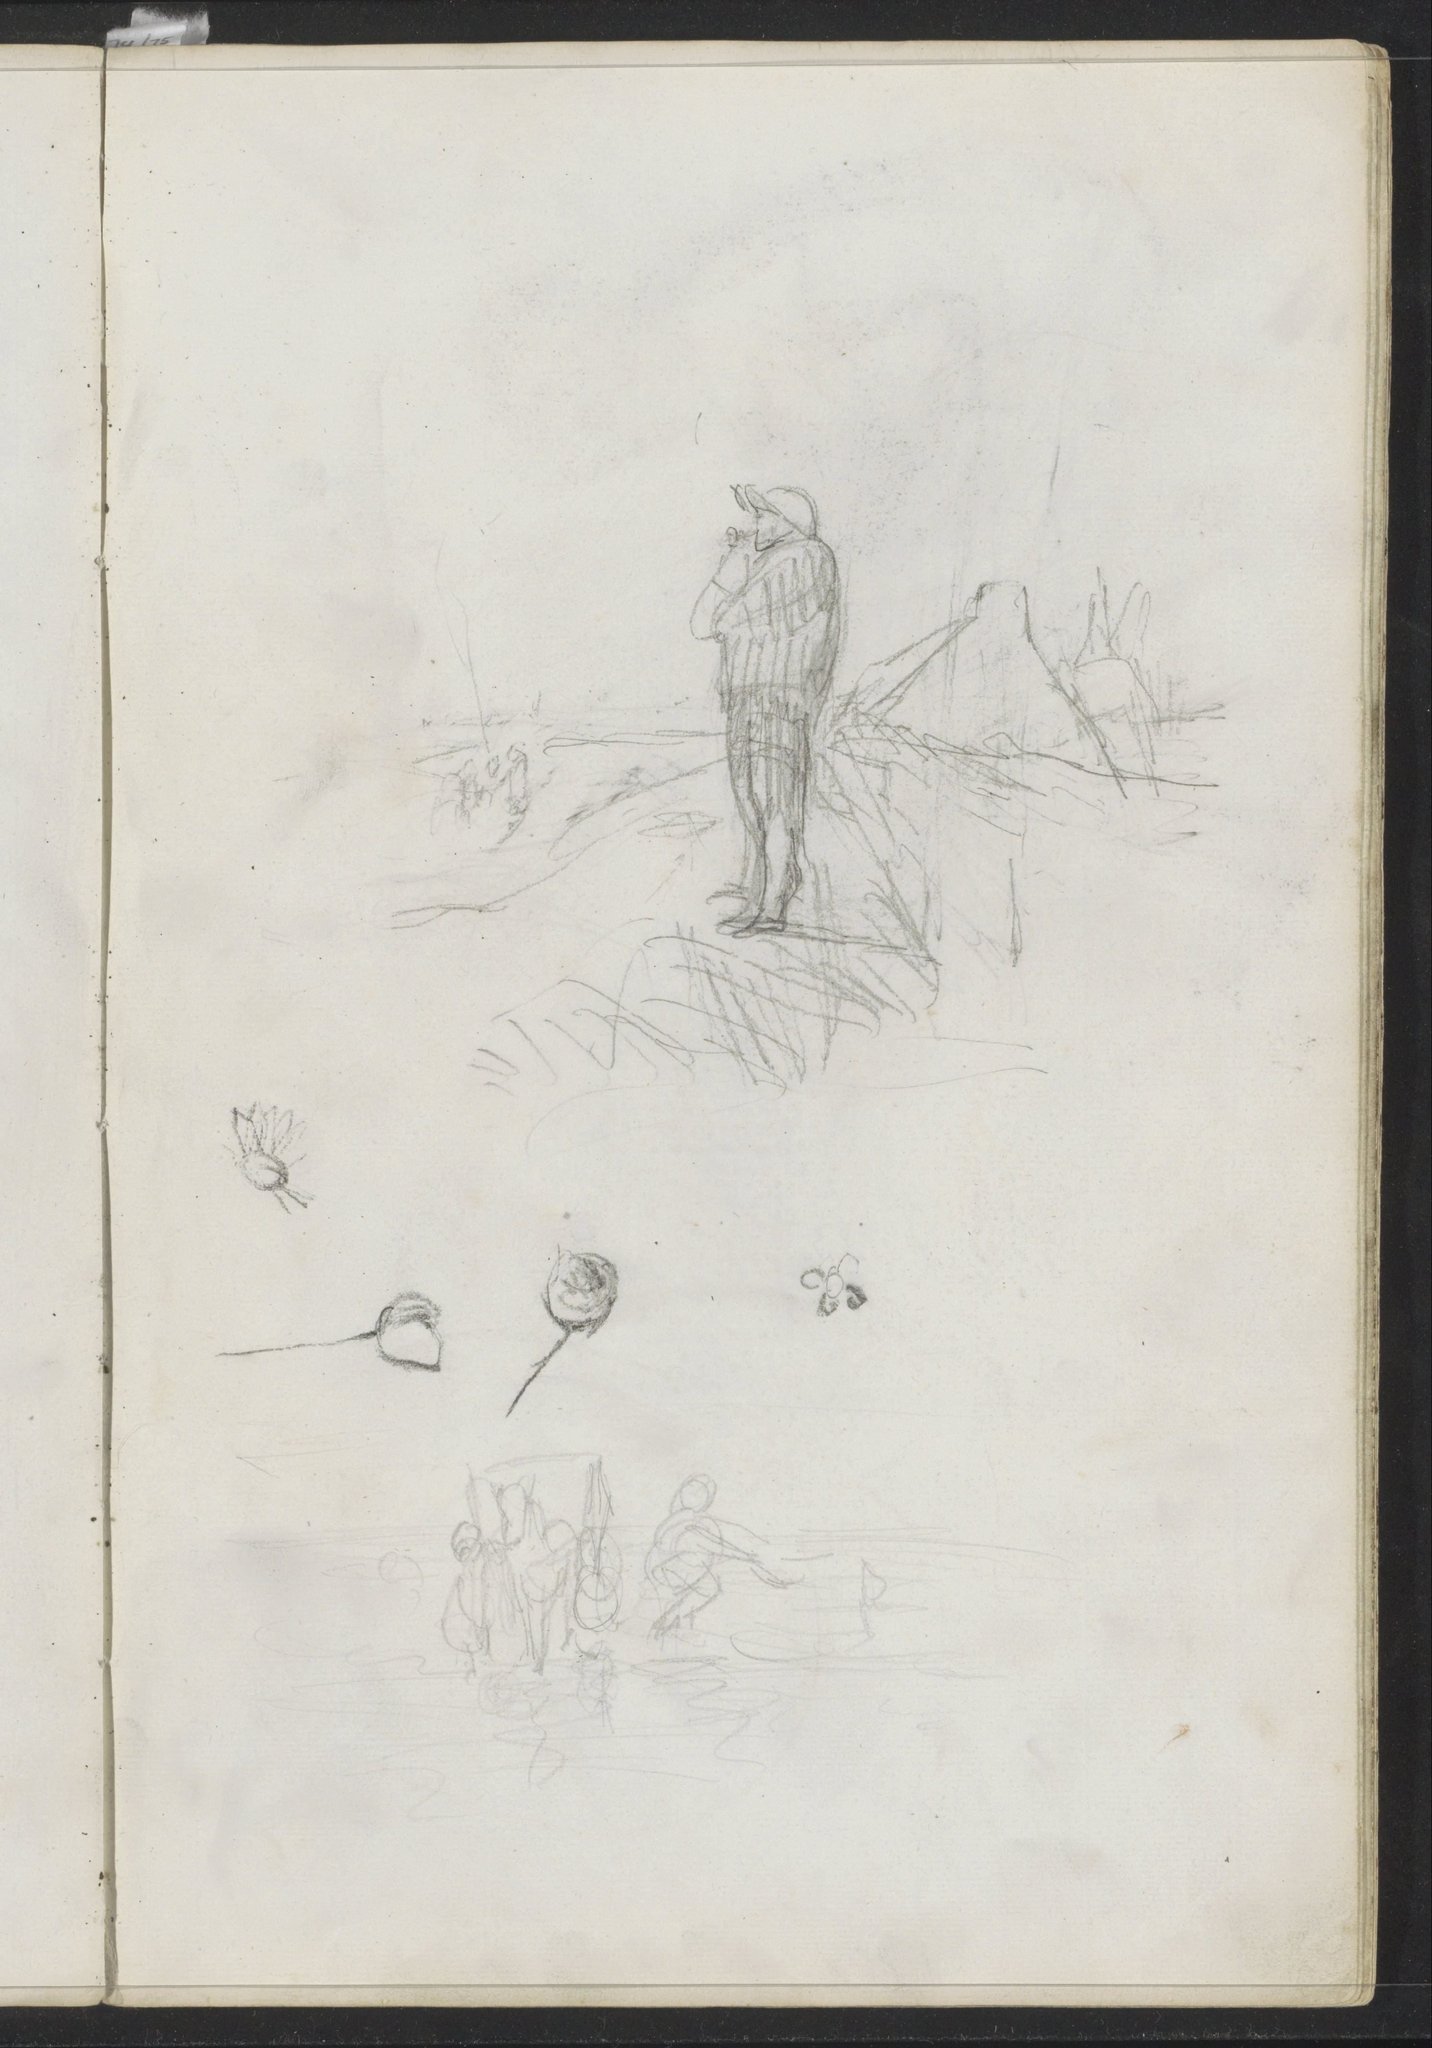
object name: sketchbook leaf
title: Rokende man op een duintop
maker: jozef israëls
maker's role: draughtsman, painter, print maker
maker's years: 1824-1911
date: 1855-1859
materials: paper, pencil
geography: zandvoort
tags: flowers, dune coast (+ landscape with figures, staffage)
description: Tevens studies van bloemen en figuren. Blad 14 recto uit een schetsboek met 22 bladen.